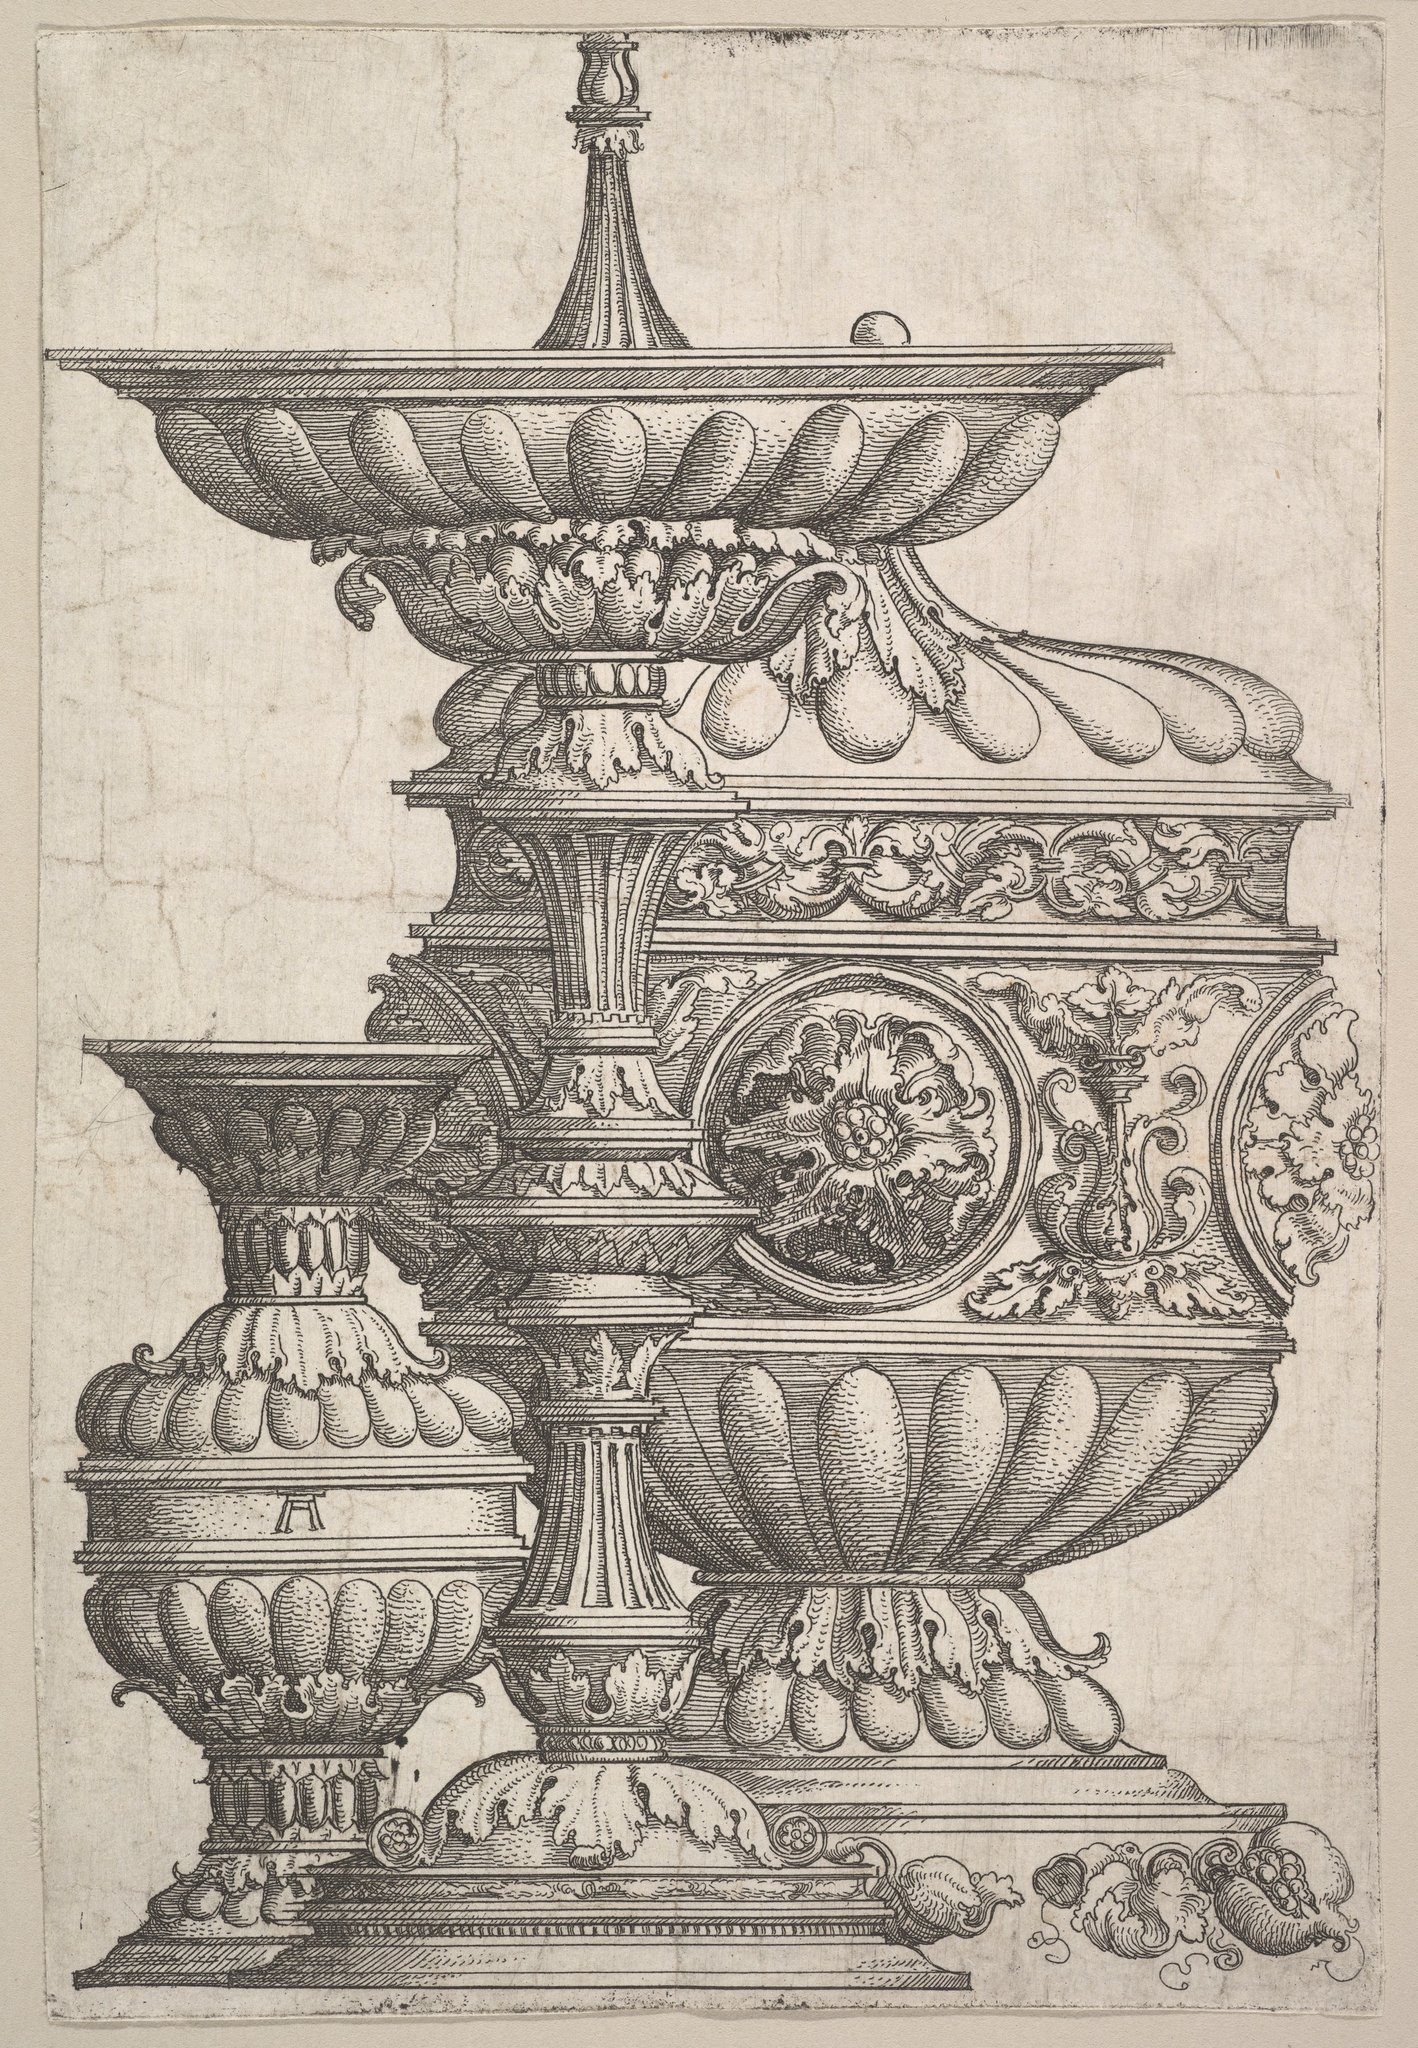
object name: print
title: Three Elegant Vessels on a White Background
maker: albrecht altdorfer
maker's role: artist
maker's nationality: german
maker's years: 1480-1538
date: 1525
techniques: etching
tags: goblets,vessels